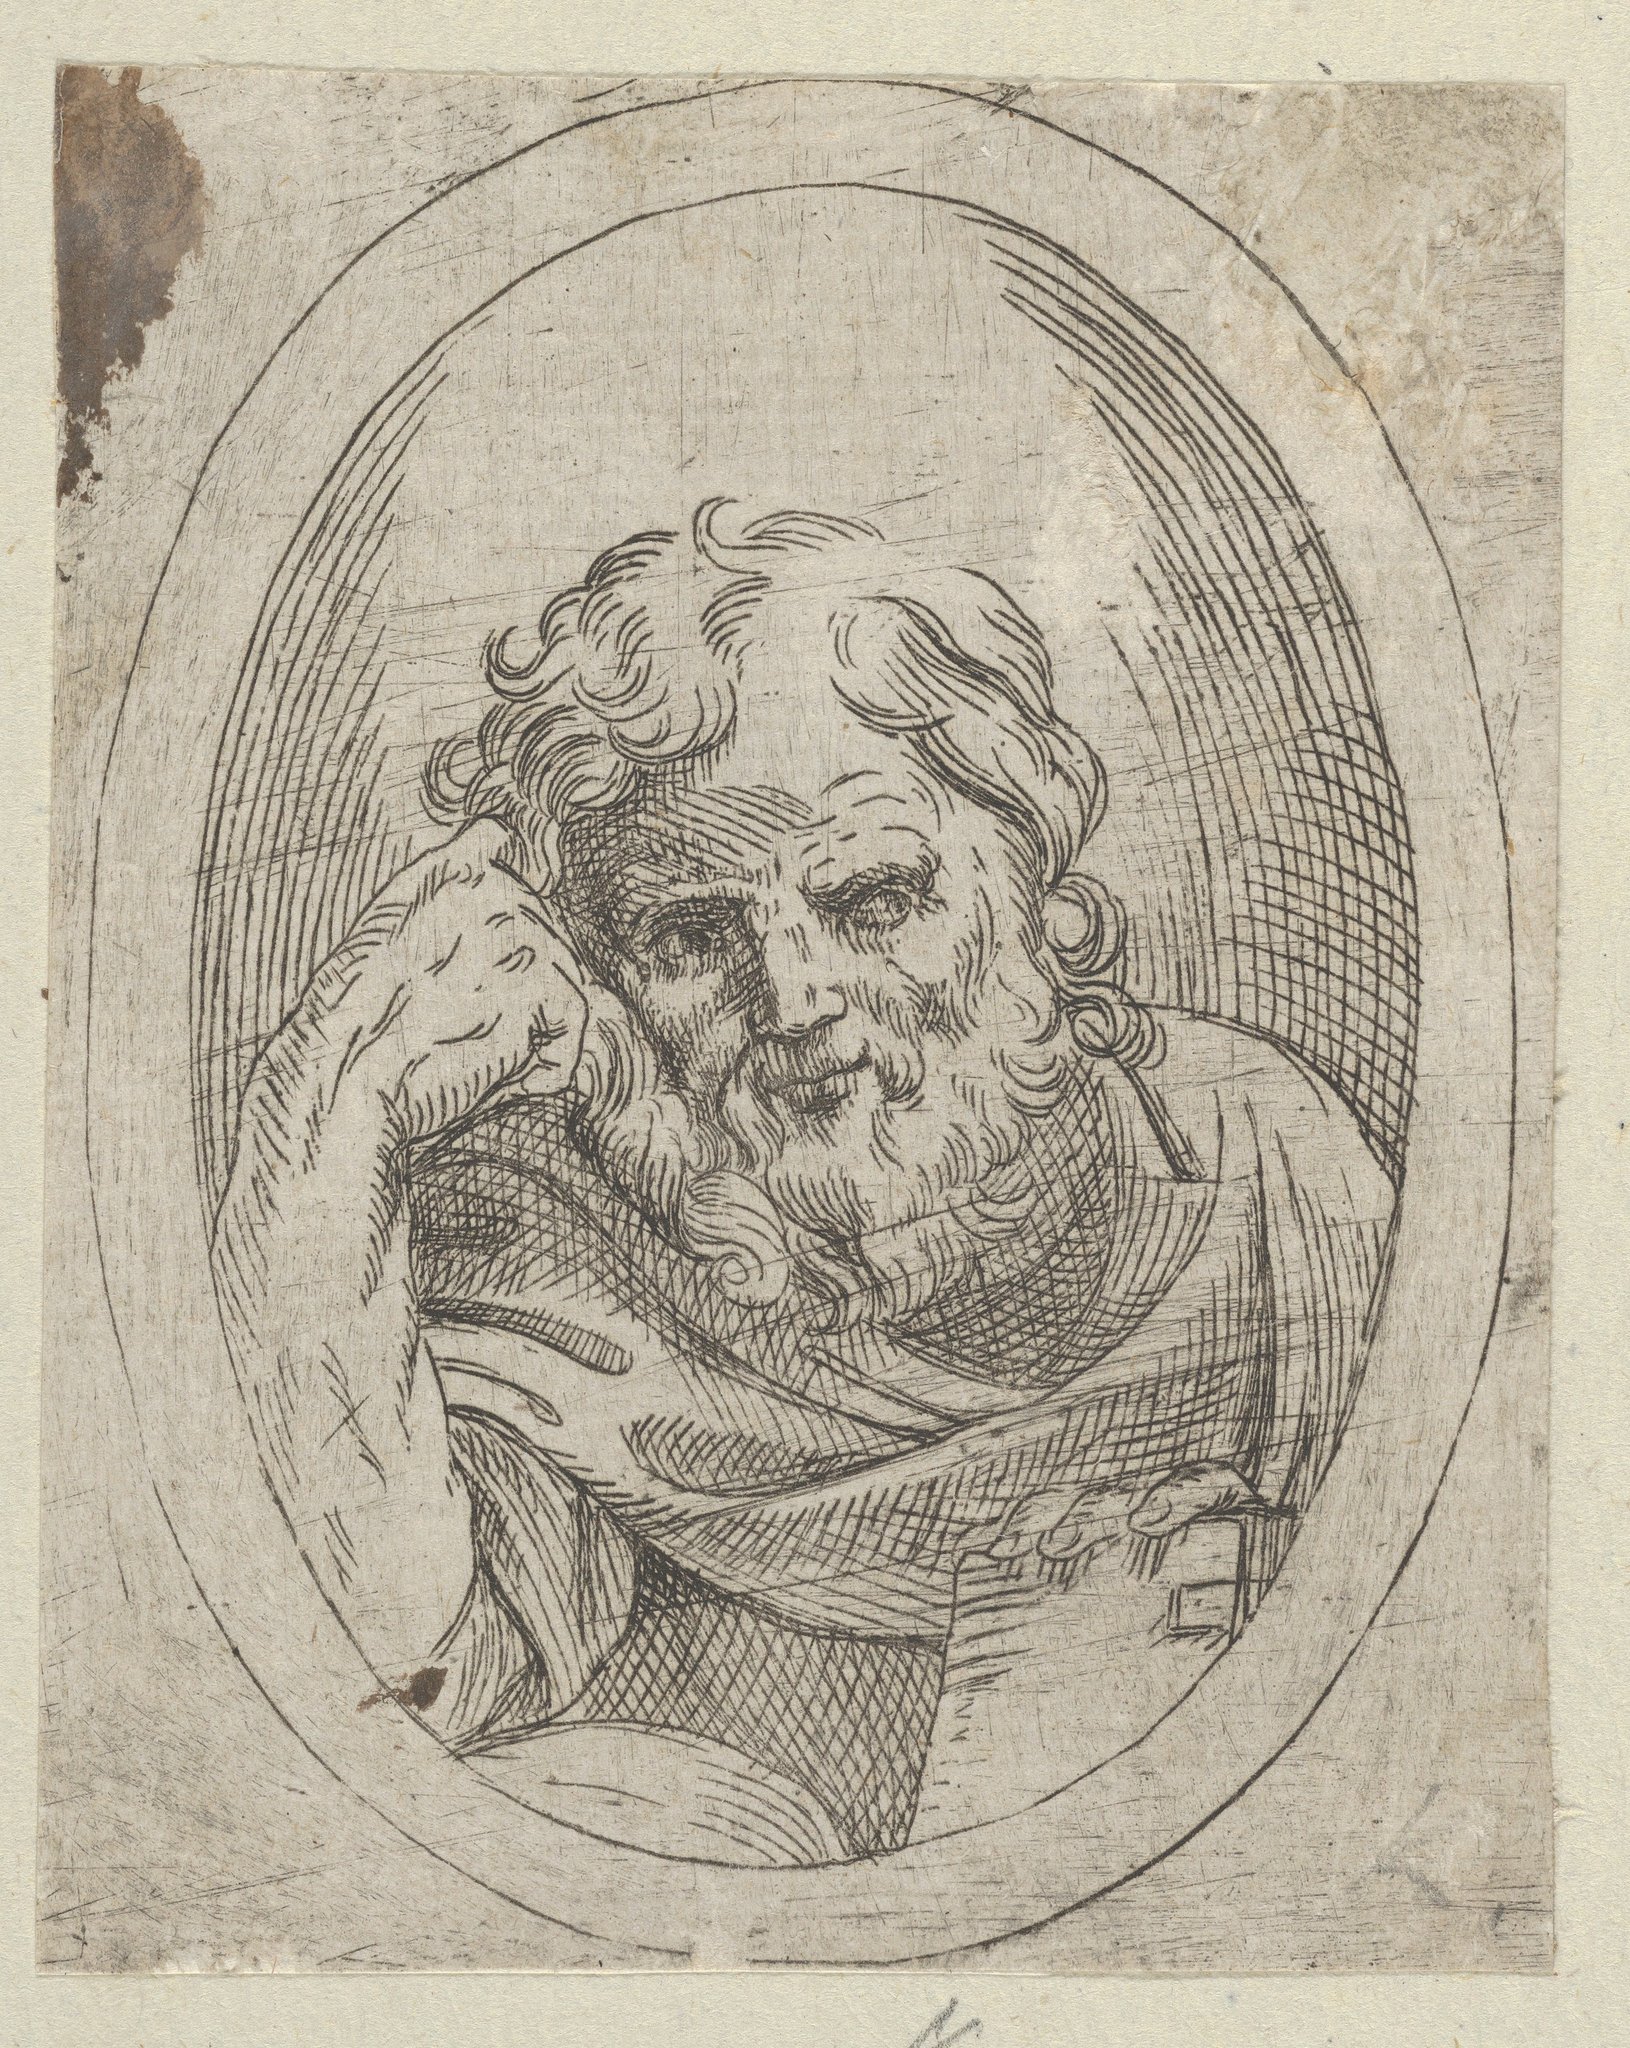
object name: print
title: An apostle resting his head on his right hand and holding a book, in an oval frame, from "Christ, the Virgin, and Thirteen Apostles"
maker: anonymous, 17th century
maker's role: artist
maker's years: 1600-1700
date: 1600-1640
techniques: etching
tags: books,portraits,apostles